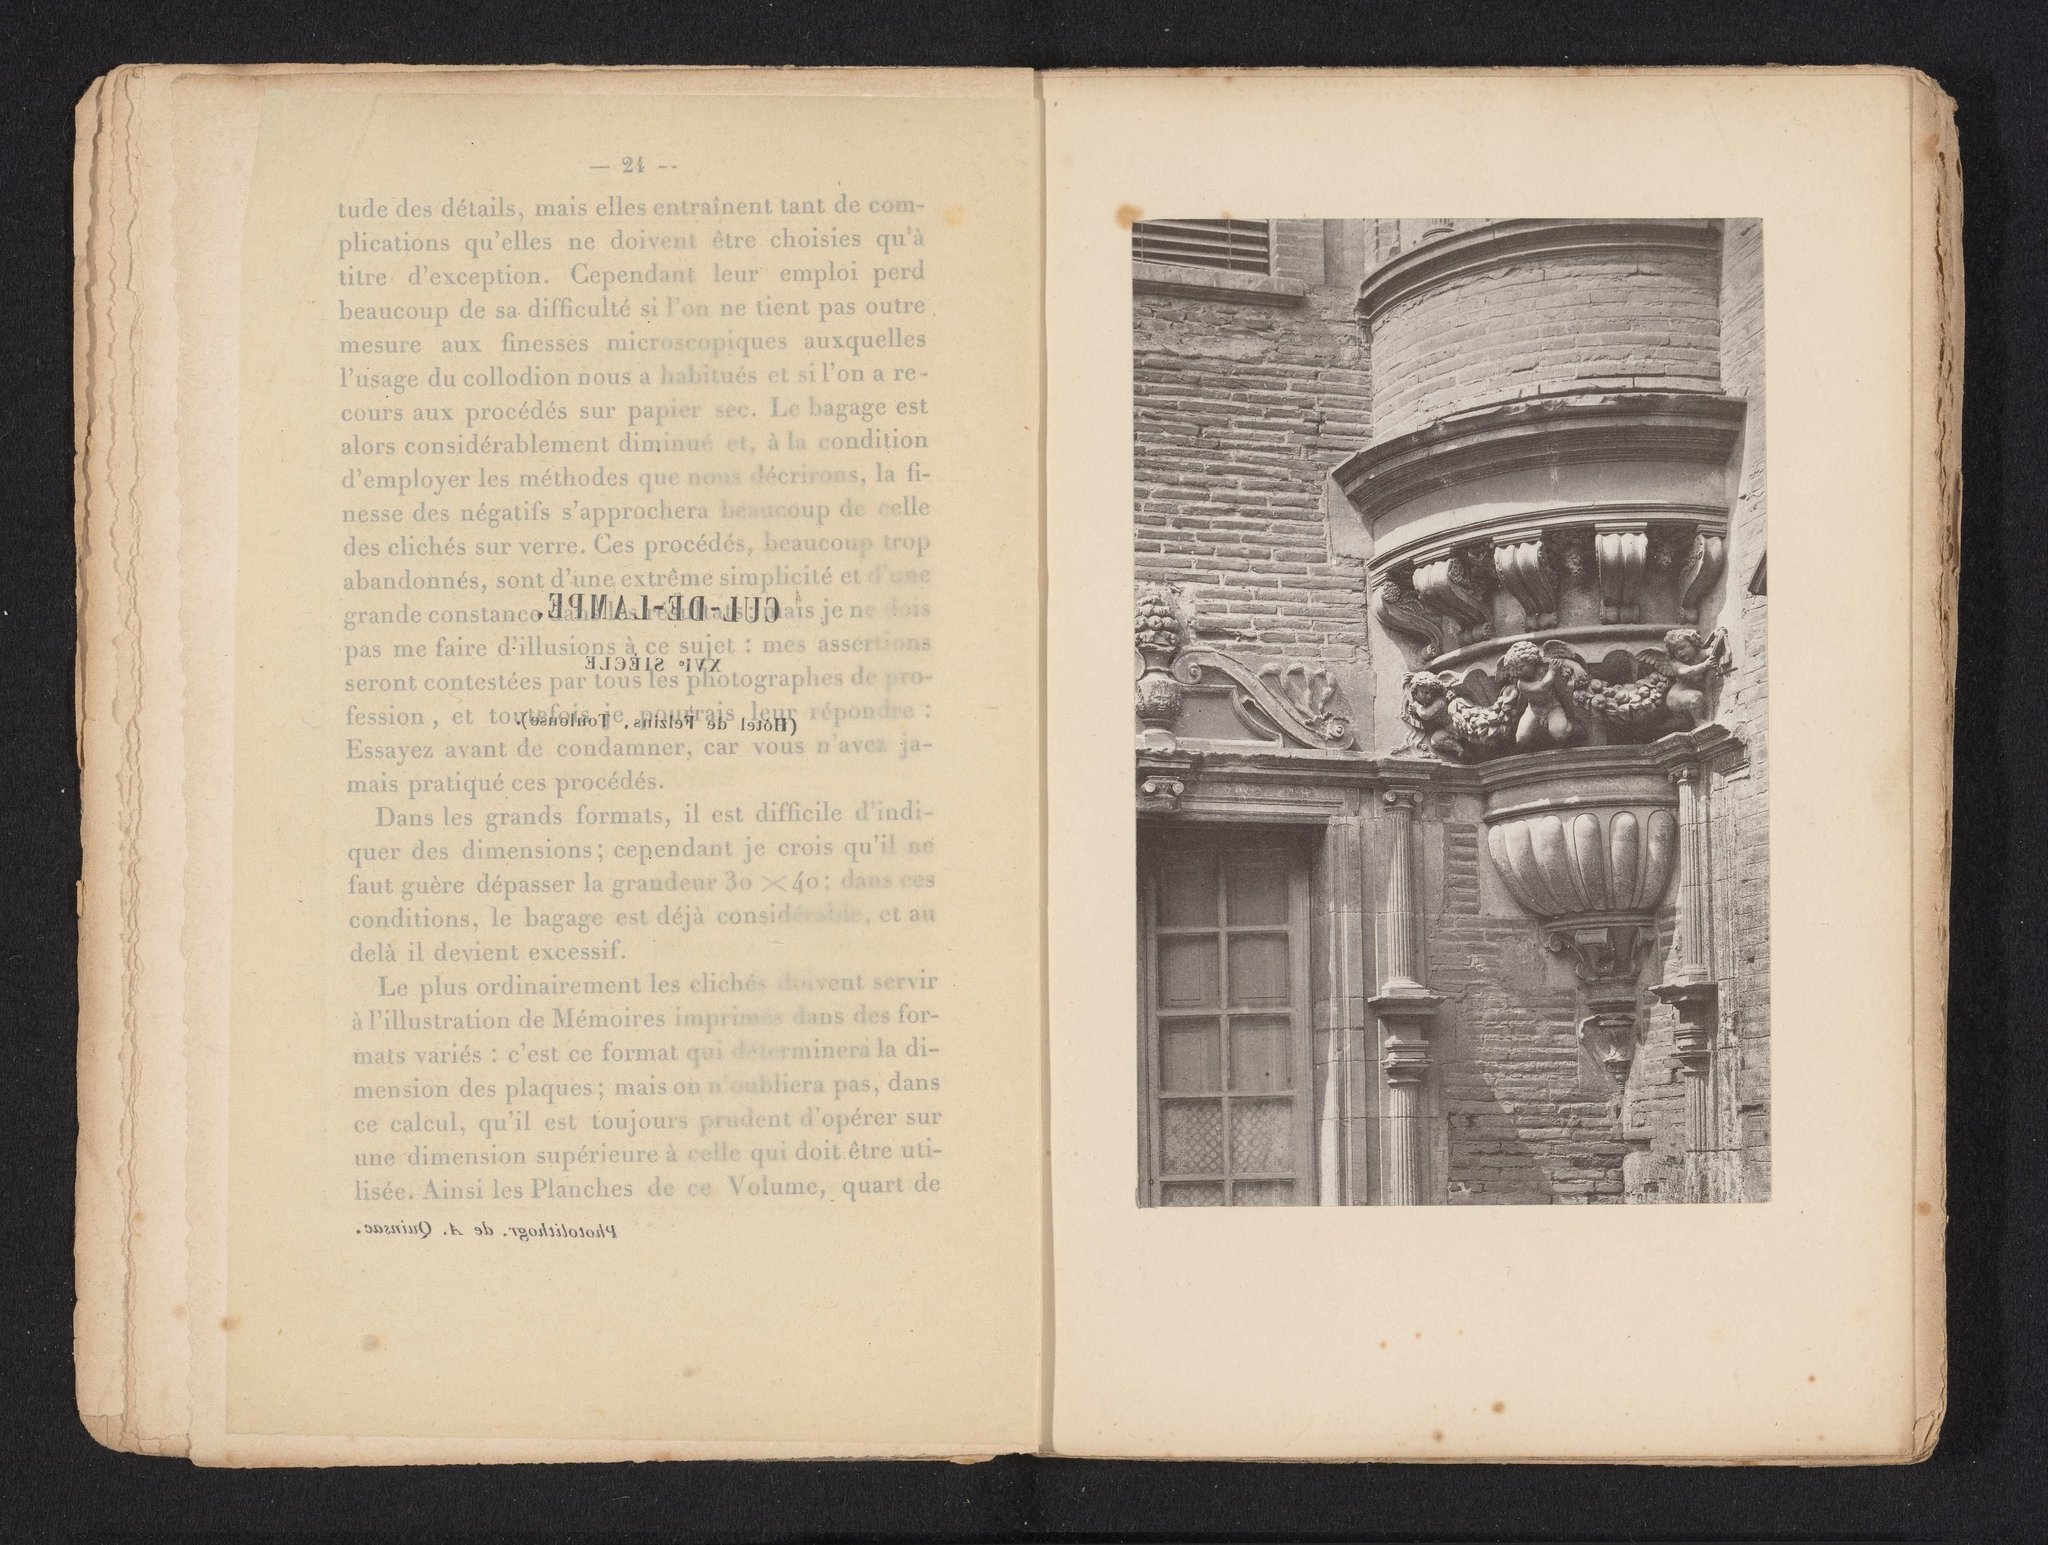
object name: page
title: Cul-de-lampe. XVIe Siècle (Hôtel de Felzins. Toulouse)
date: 1869-1879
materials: paper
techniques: photograph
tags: cupids: 'amores', 'amoretti', 'putti'